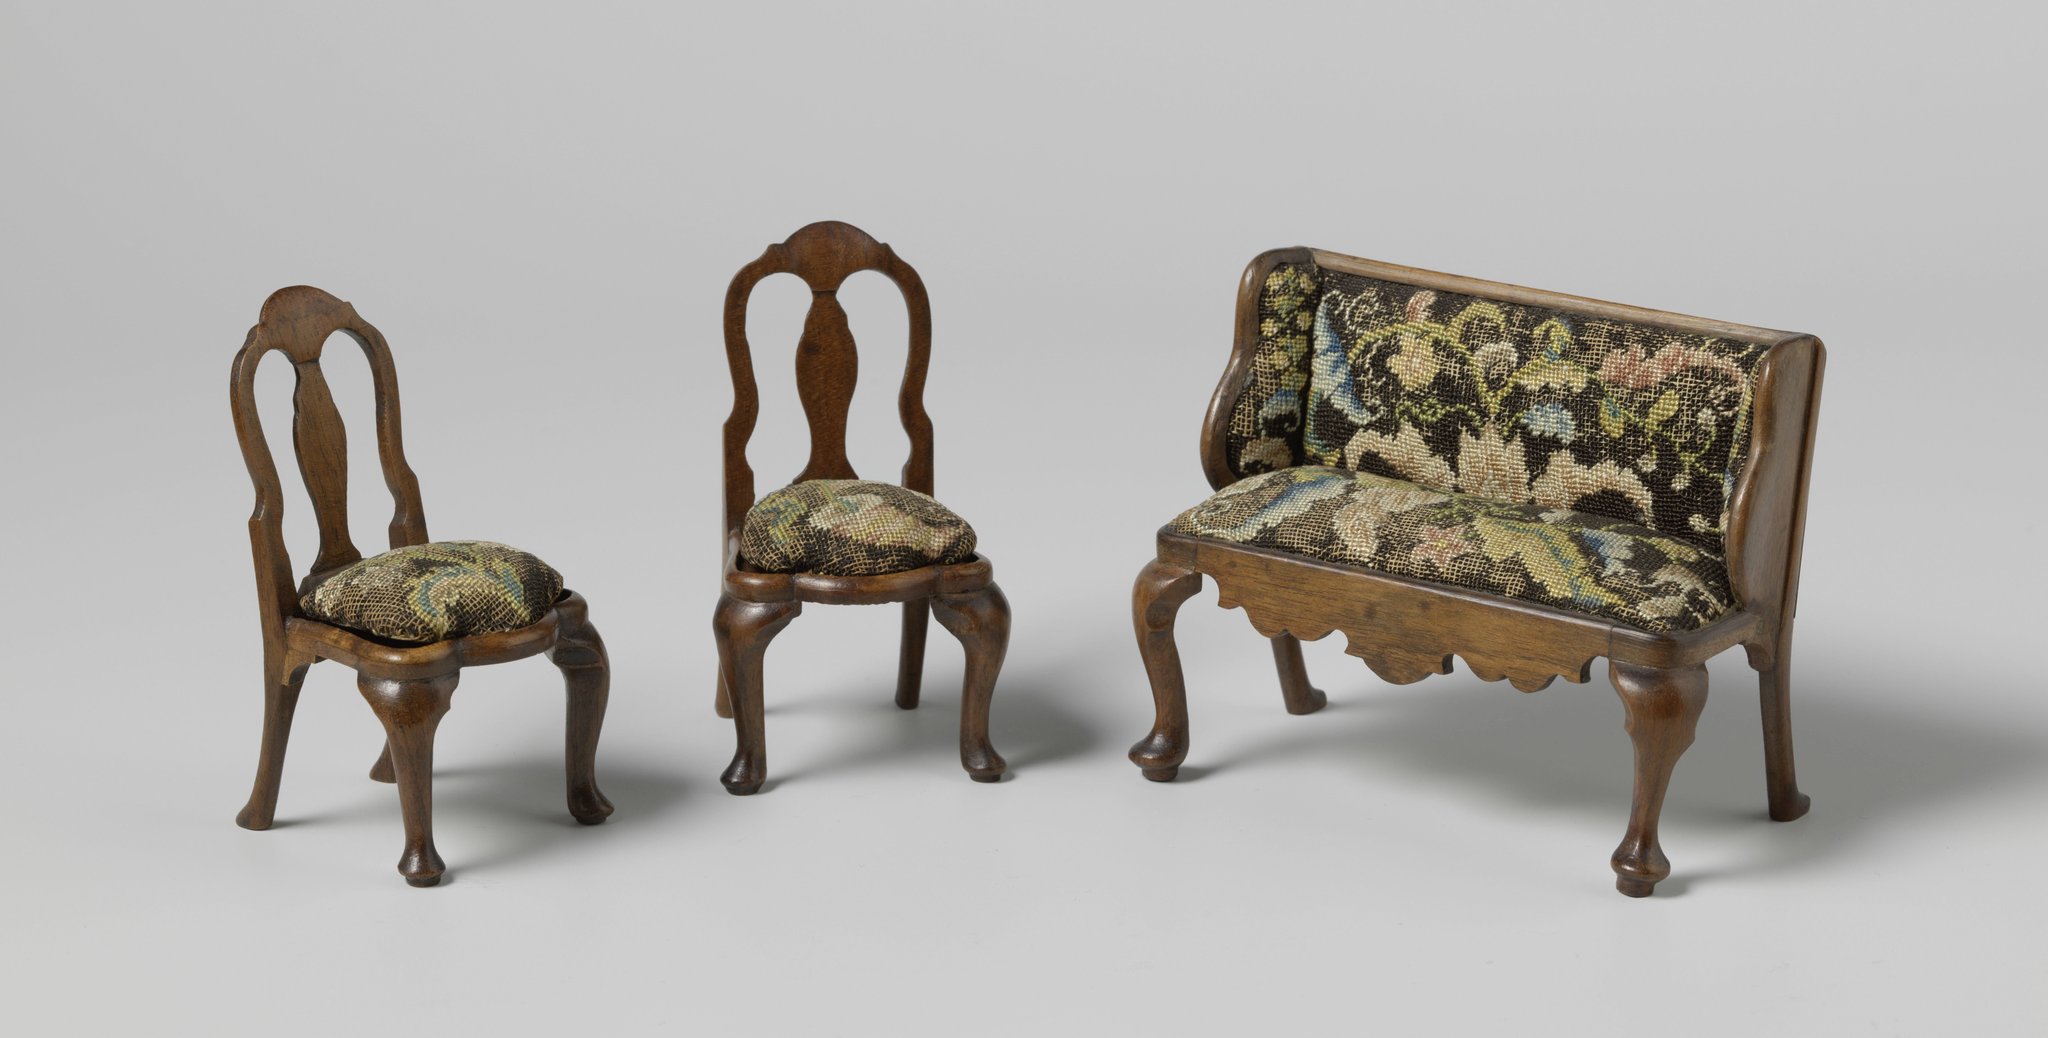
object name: miniature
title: Ameublement, bestaande uit een bank en tien stoelen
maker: Anonymous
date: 1750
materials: silk, wood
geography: amsterdam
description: Ameublement, vervaardigd van notenhout, bestaande uit een bank en tien stoelen. De zitting van buurduurwerk met blad- en bloemmotieven in zijde op linnen stramien, met een zachte vulling.